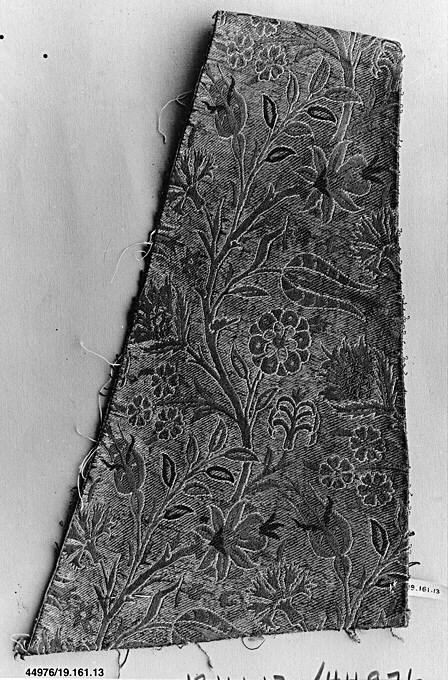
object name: textile fragment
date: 1501-1700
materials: silk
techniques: brocade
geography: turkey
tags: flowers,leaves